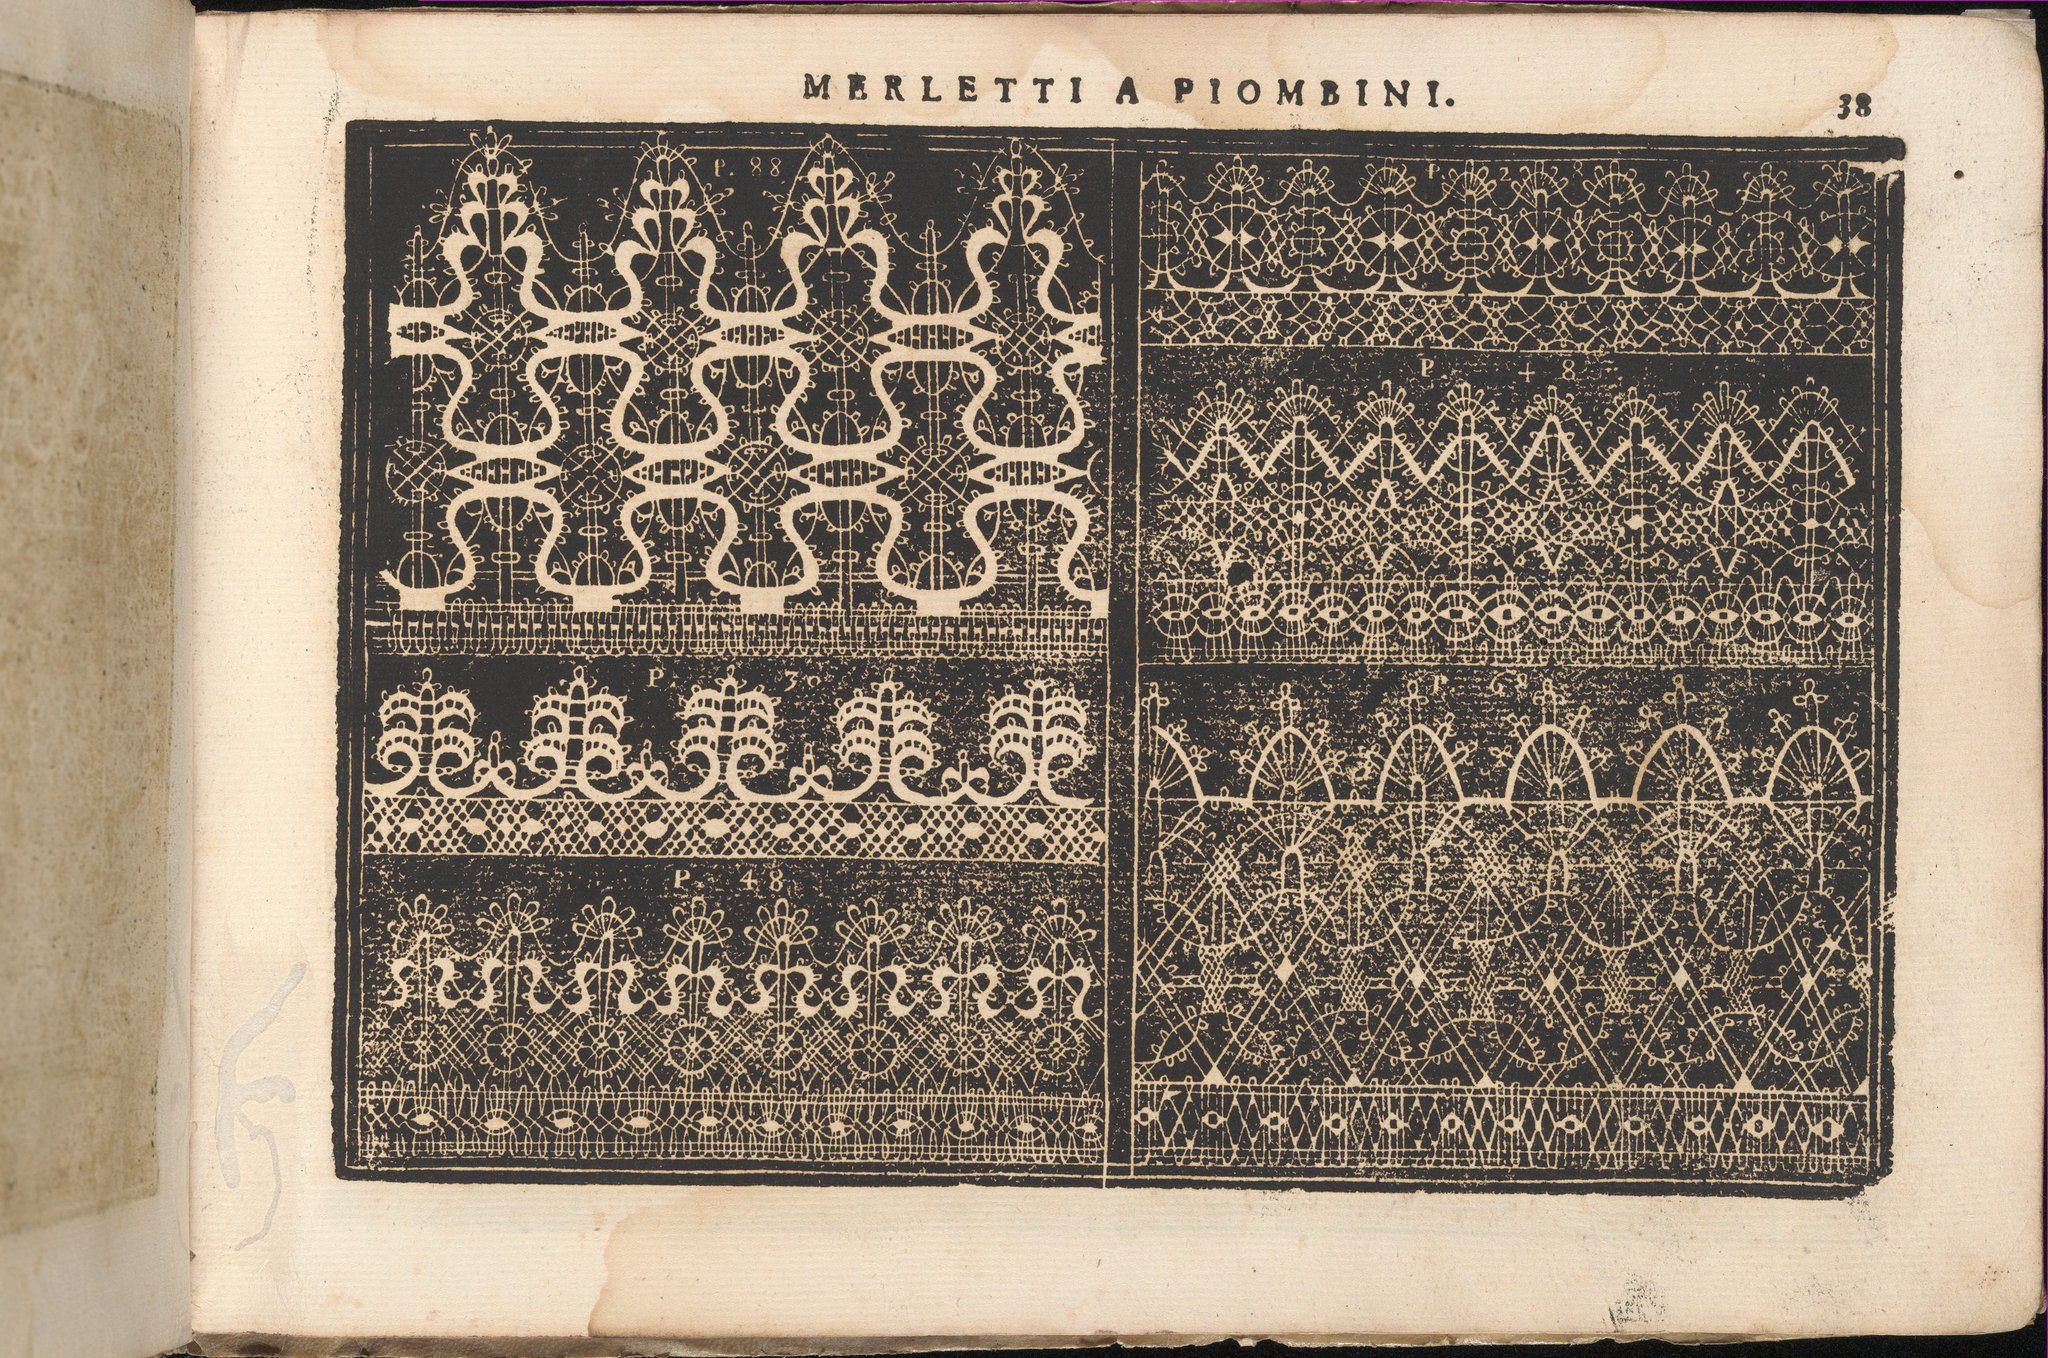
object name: book print ornament architecture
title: Teatro delle Nobili et Virtuose Donne..., page 38 (recto)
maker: isabella catanea parasole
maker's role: author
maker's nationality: italian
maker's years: 1565-1625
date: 1616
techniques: engraving, woodcut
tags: ornament